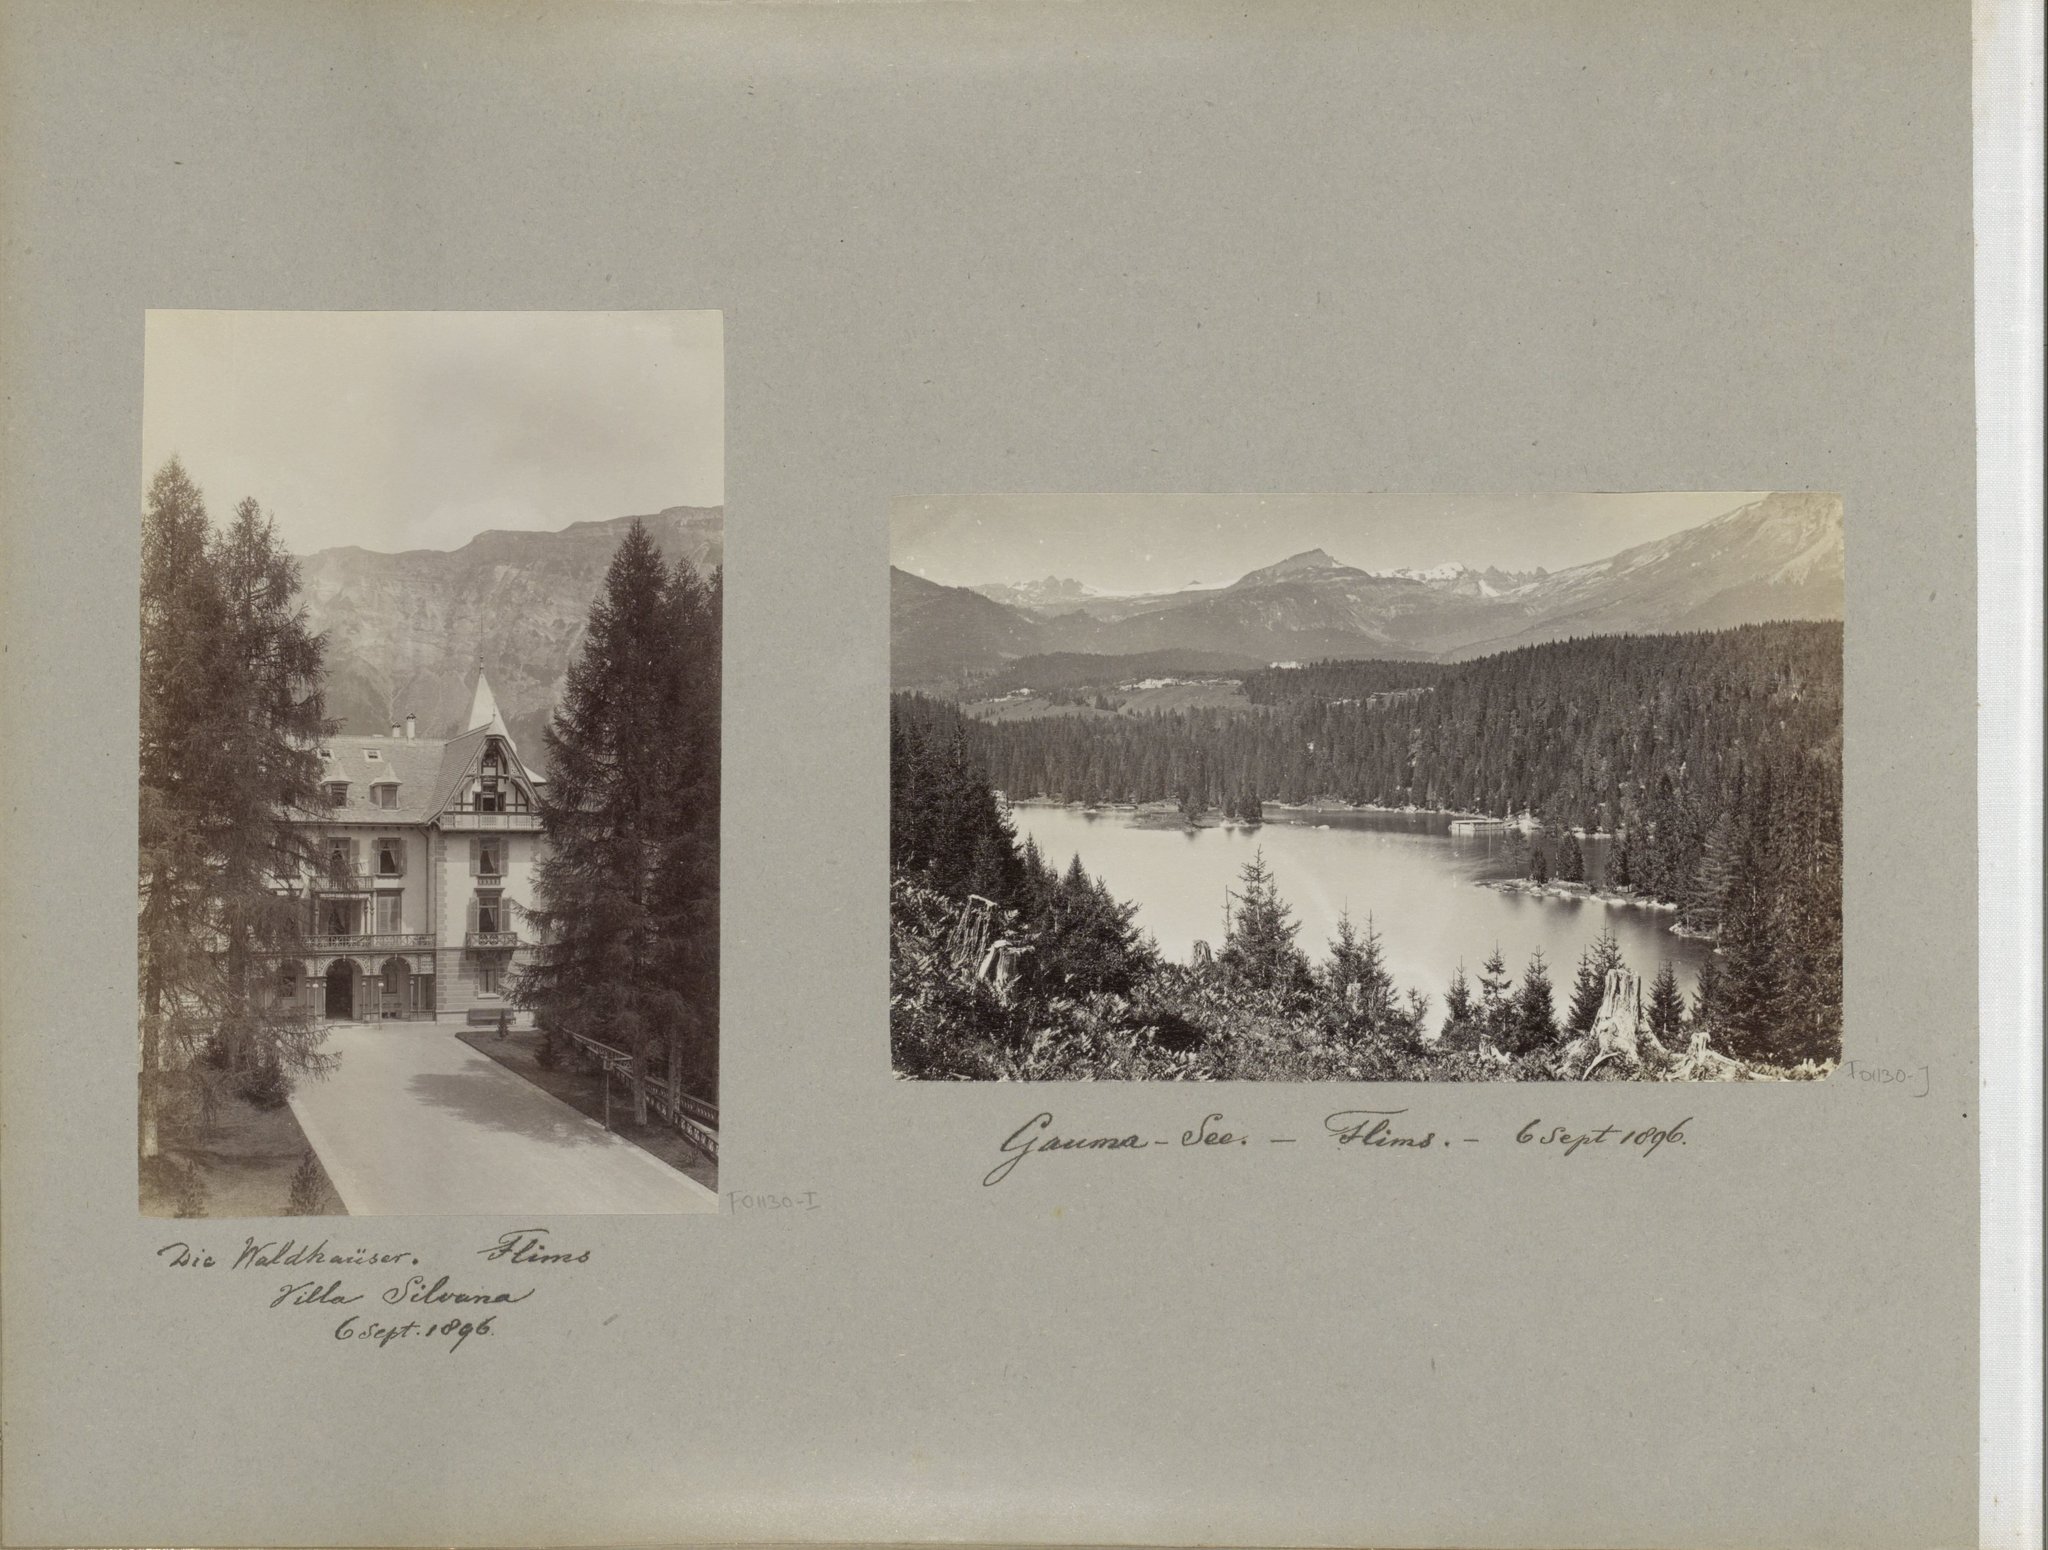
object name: photograph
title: Exterieur van Villa Silvana in Flims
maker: Anonymous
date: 1880-1896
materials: paper, photographic support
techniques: albumen print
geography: flims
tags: rural housing, e.g. country-house, villa, cottage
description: Onderdeel van Reisalbum met foto's van bezienswaardigheden in Frankrijk, Spanje, Italië, Duitsland, Zwitserland en Oostenrijk.